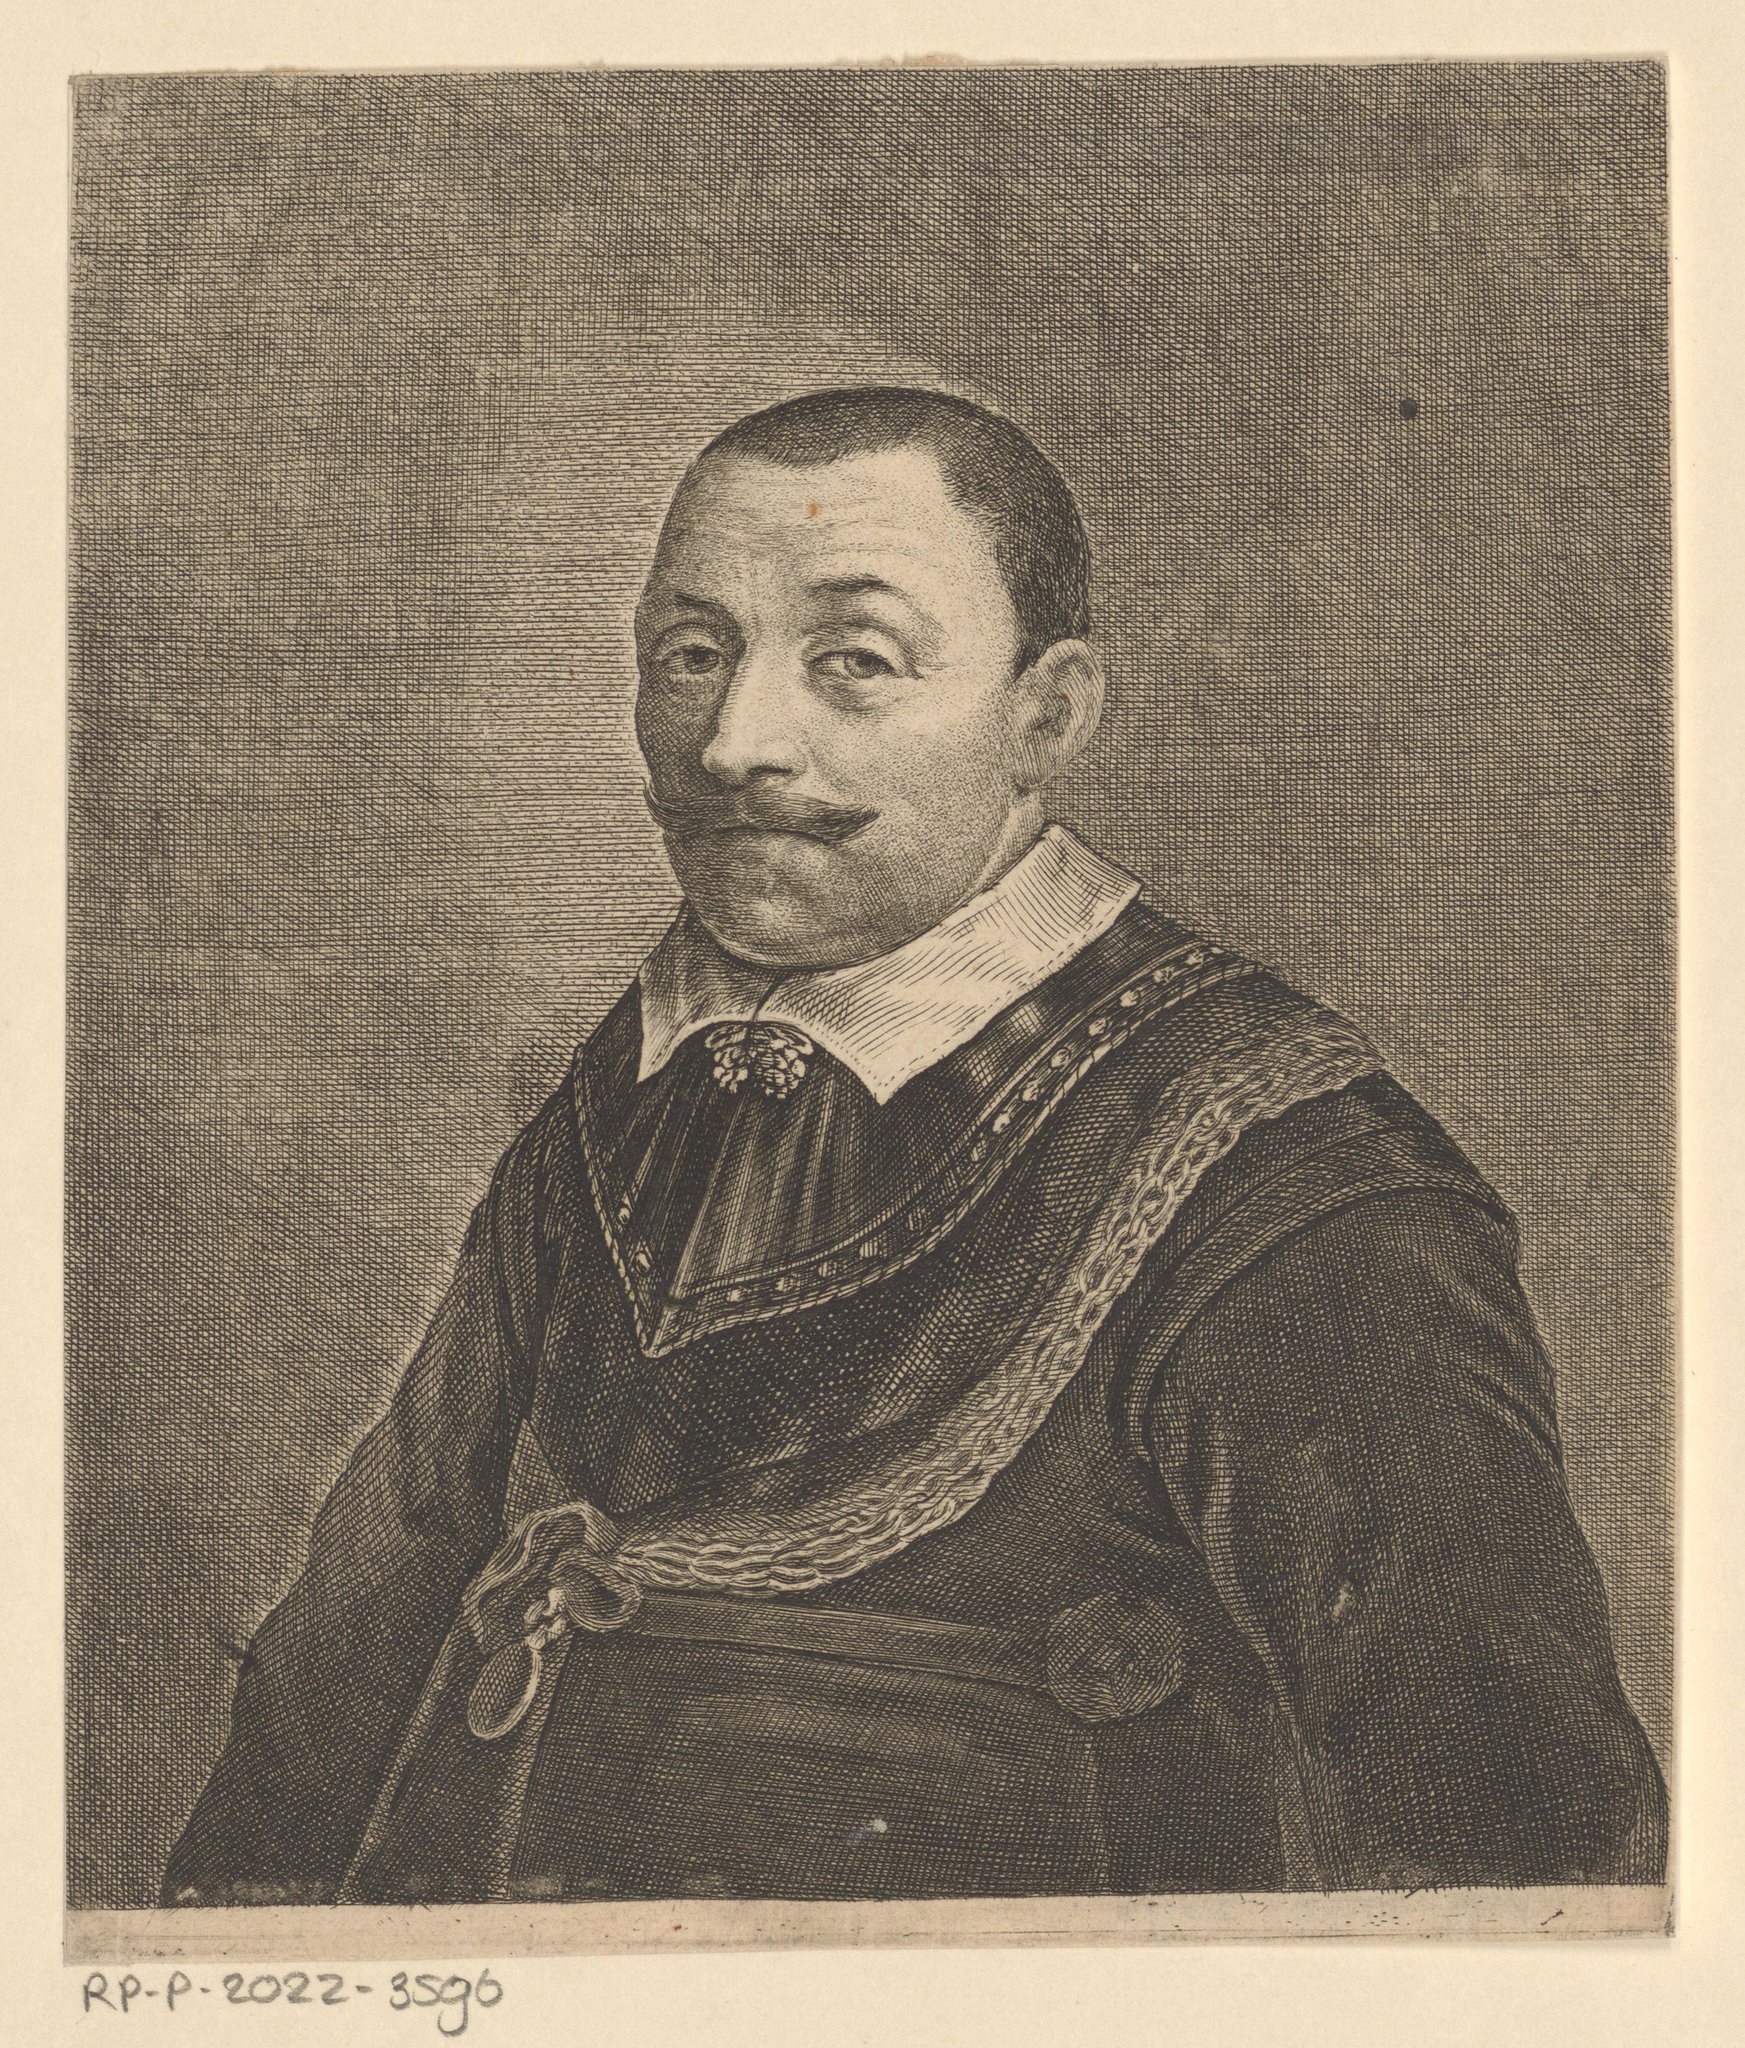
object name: print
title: Portret van Maarten Harpertszoon Tromp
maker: salomon savery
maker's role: print maker, publisher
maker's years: 1594-1683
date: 1630-1683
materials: paper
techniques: engraving, etching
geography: amsterdam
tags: maarten harpertszoon tromp, historical persons, commander-in-chief, admiral